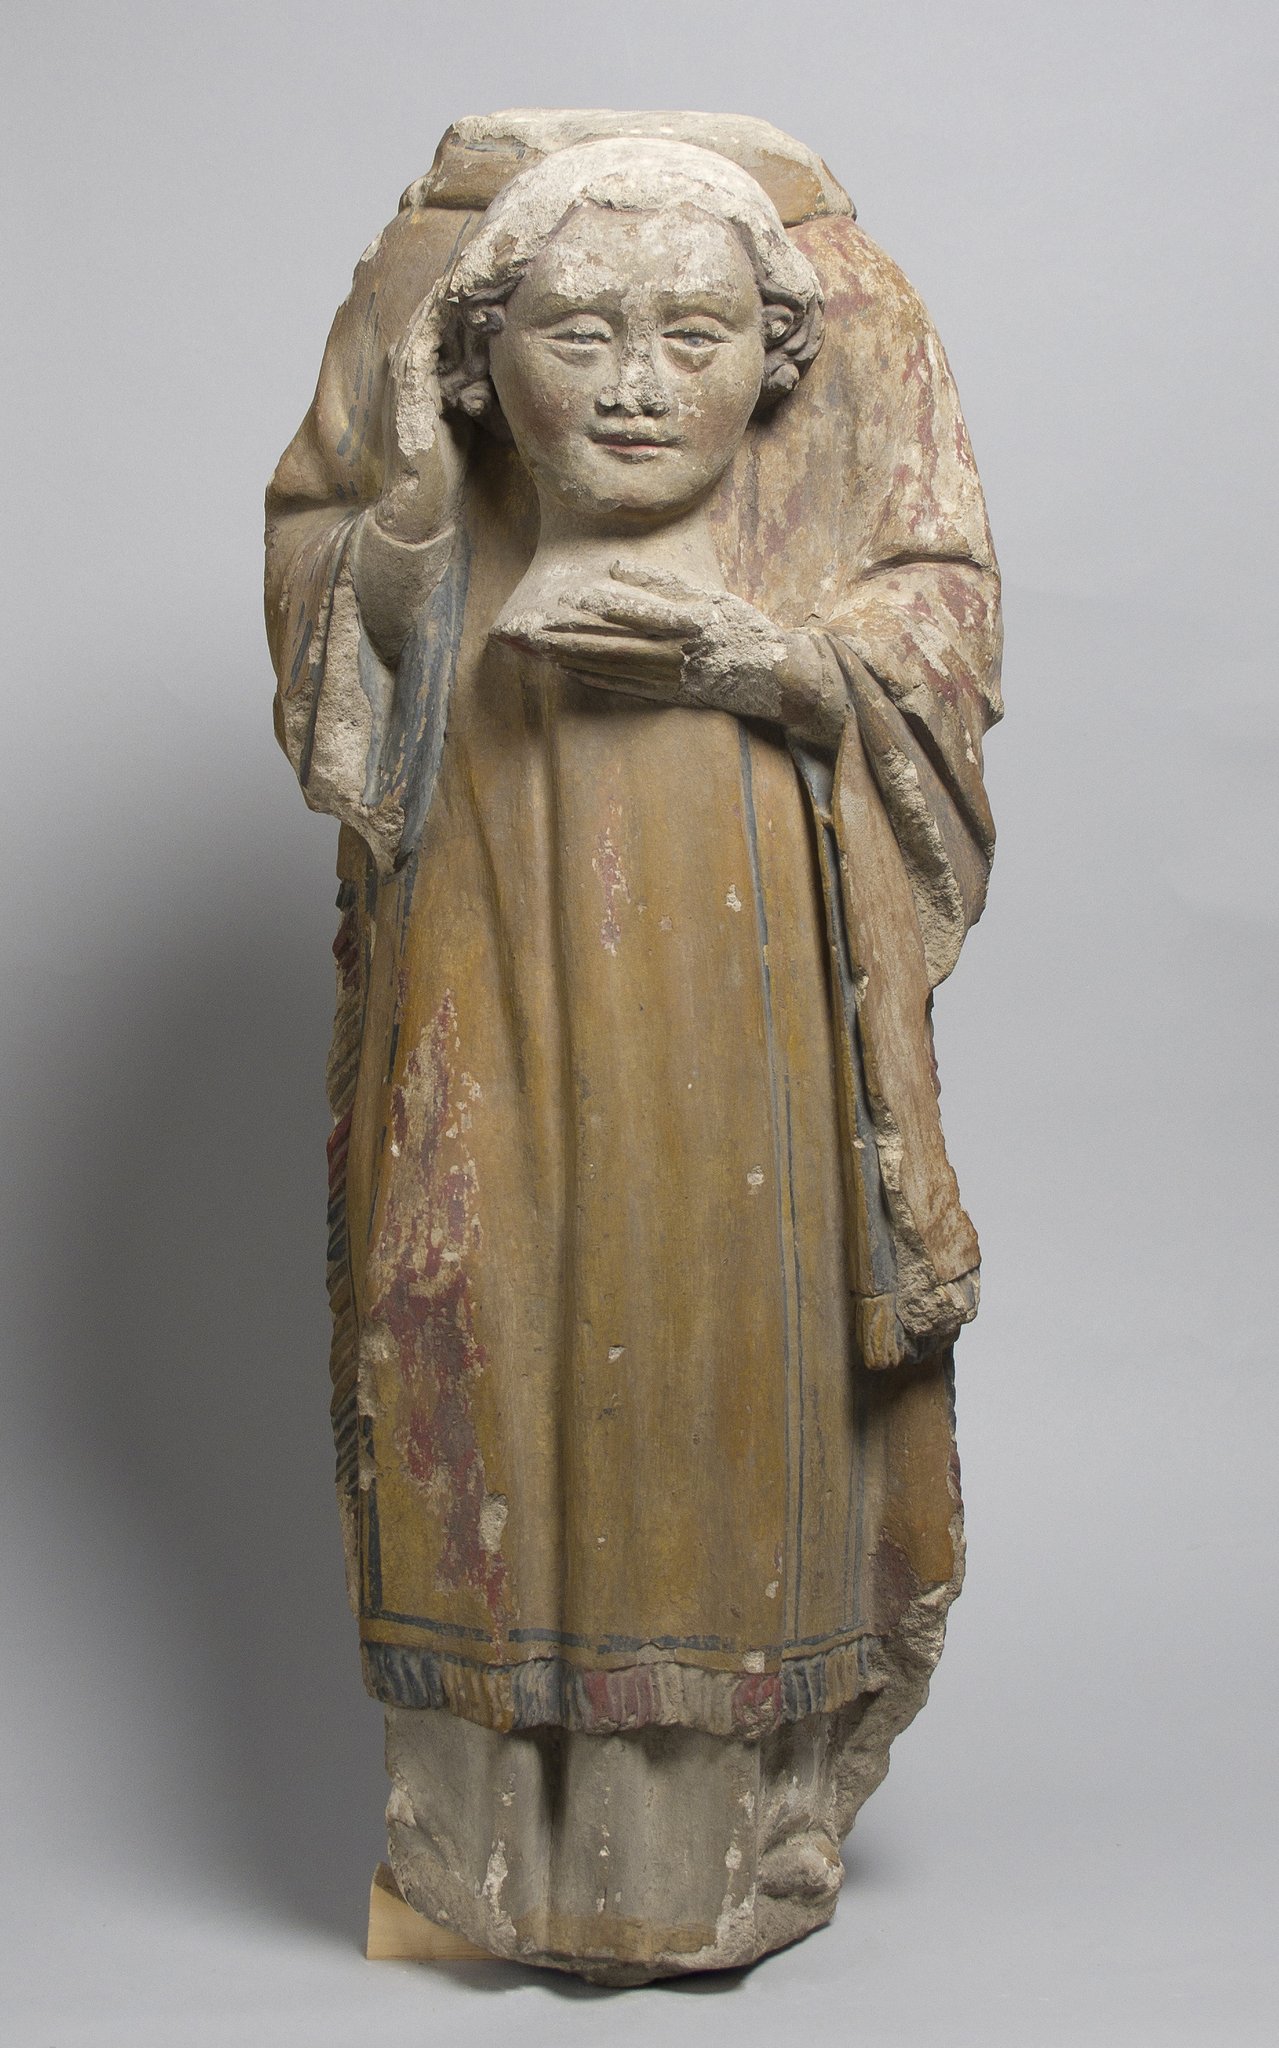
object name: statuette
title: Saint Eleuthere or Saint Rustique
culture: french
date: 1301-1400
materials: paint, stone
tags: heads,saints